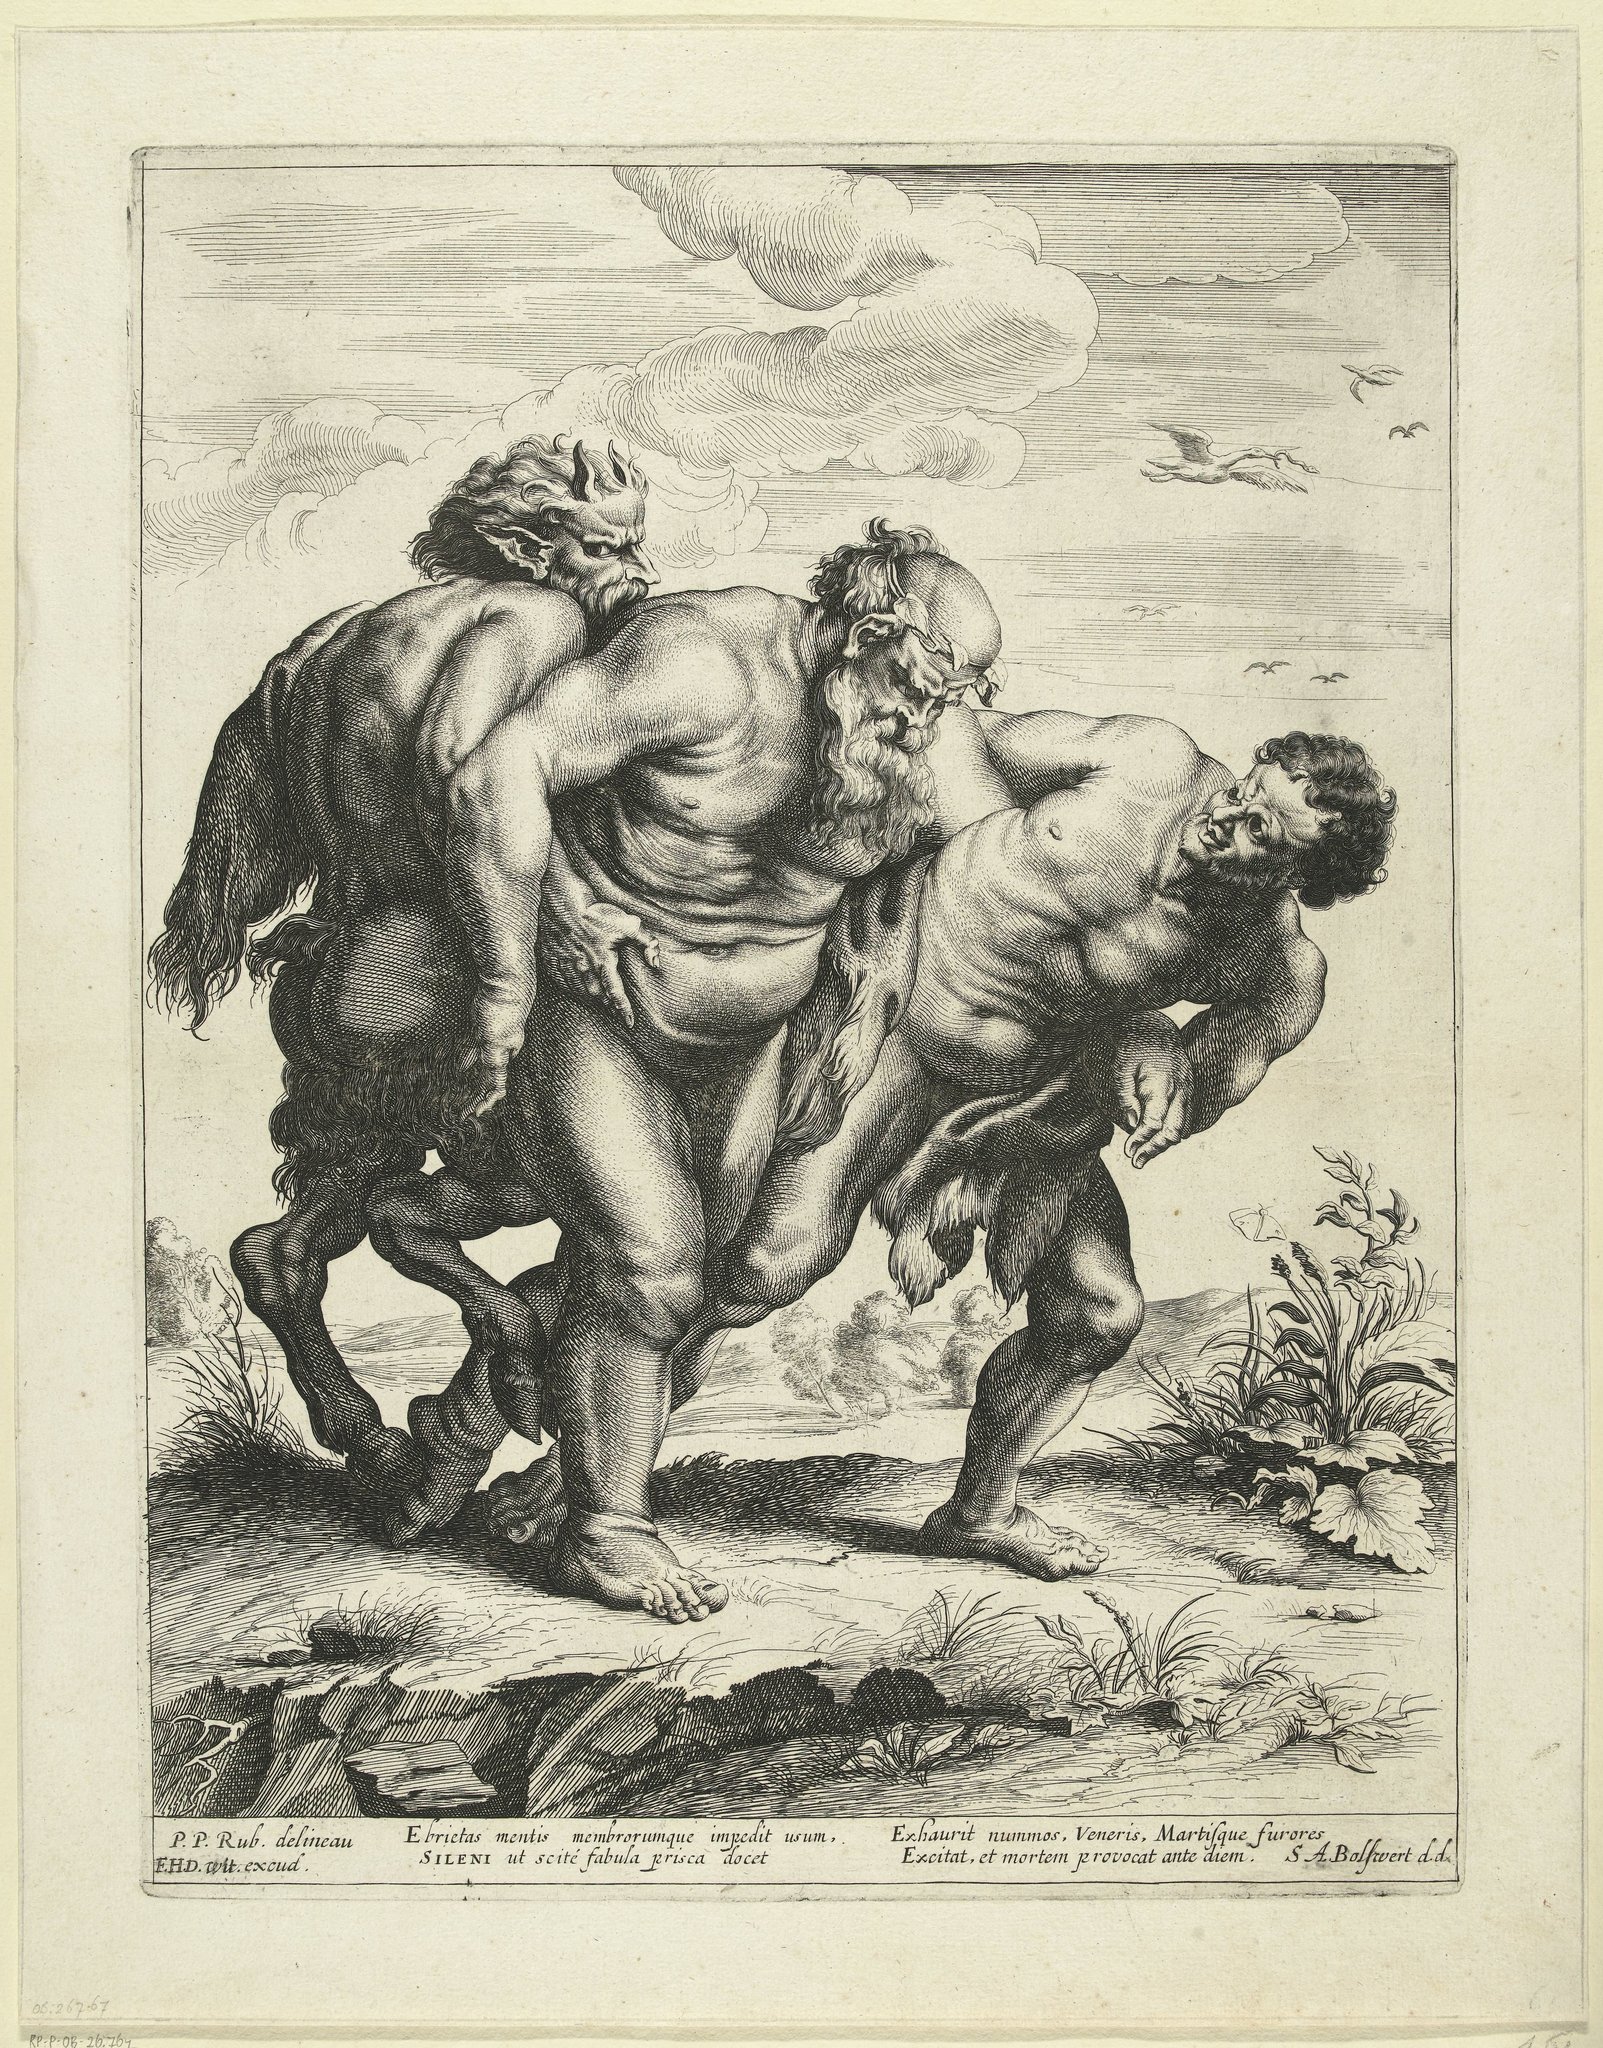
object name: print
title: Saters ondersteunen dronken Silenus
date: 1596-1659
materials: paper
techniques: engraving, etching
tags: (story of) silenus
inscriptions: collector's mark: Lugt 240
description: Saters ondersteunen de dronken Silenus. Onder de voorstelling staat een vers in Latijn.